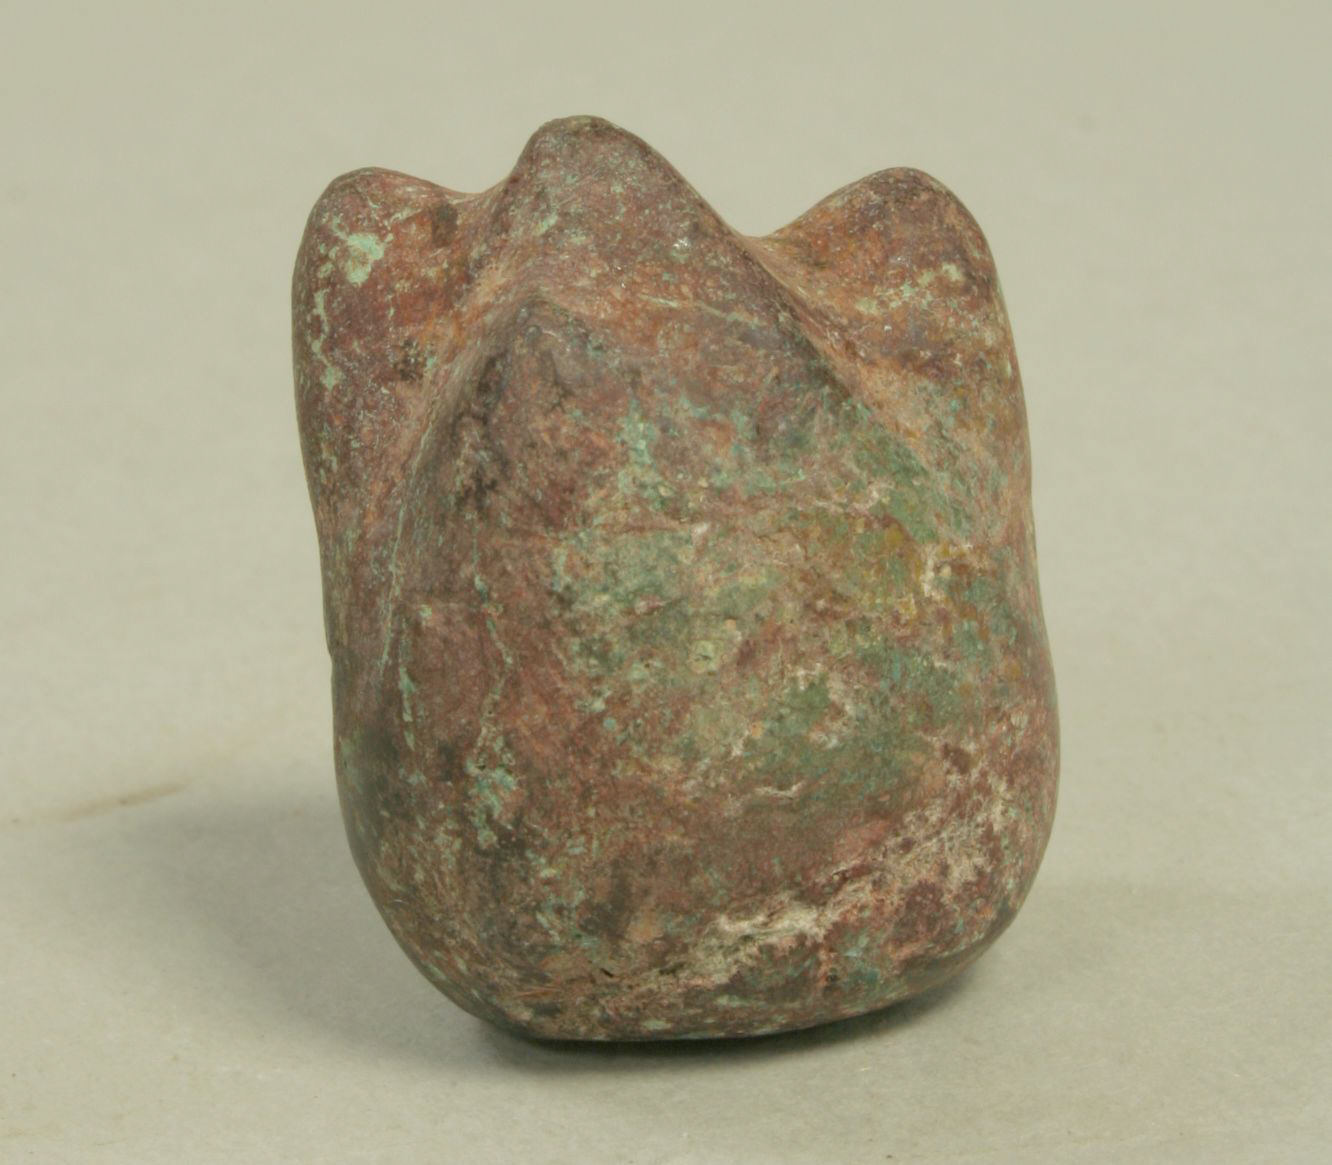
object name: religious ritual object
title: Ritual Object (?)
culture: moche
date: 1-766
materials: stone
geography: peru